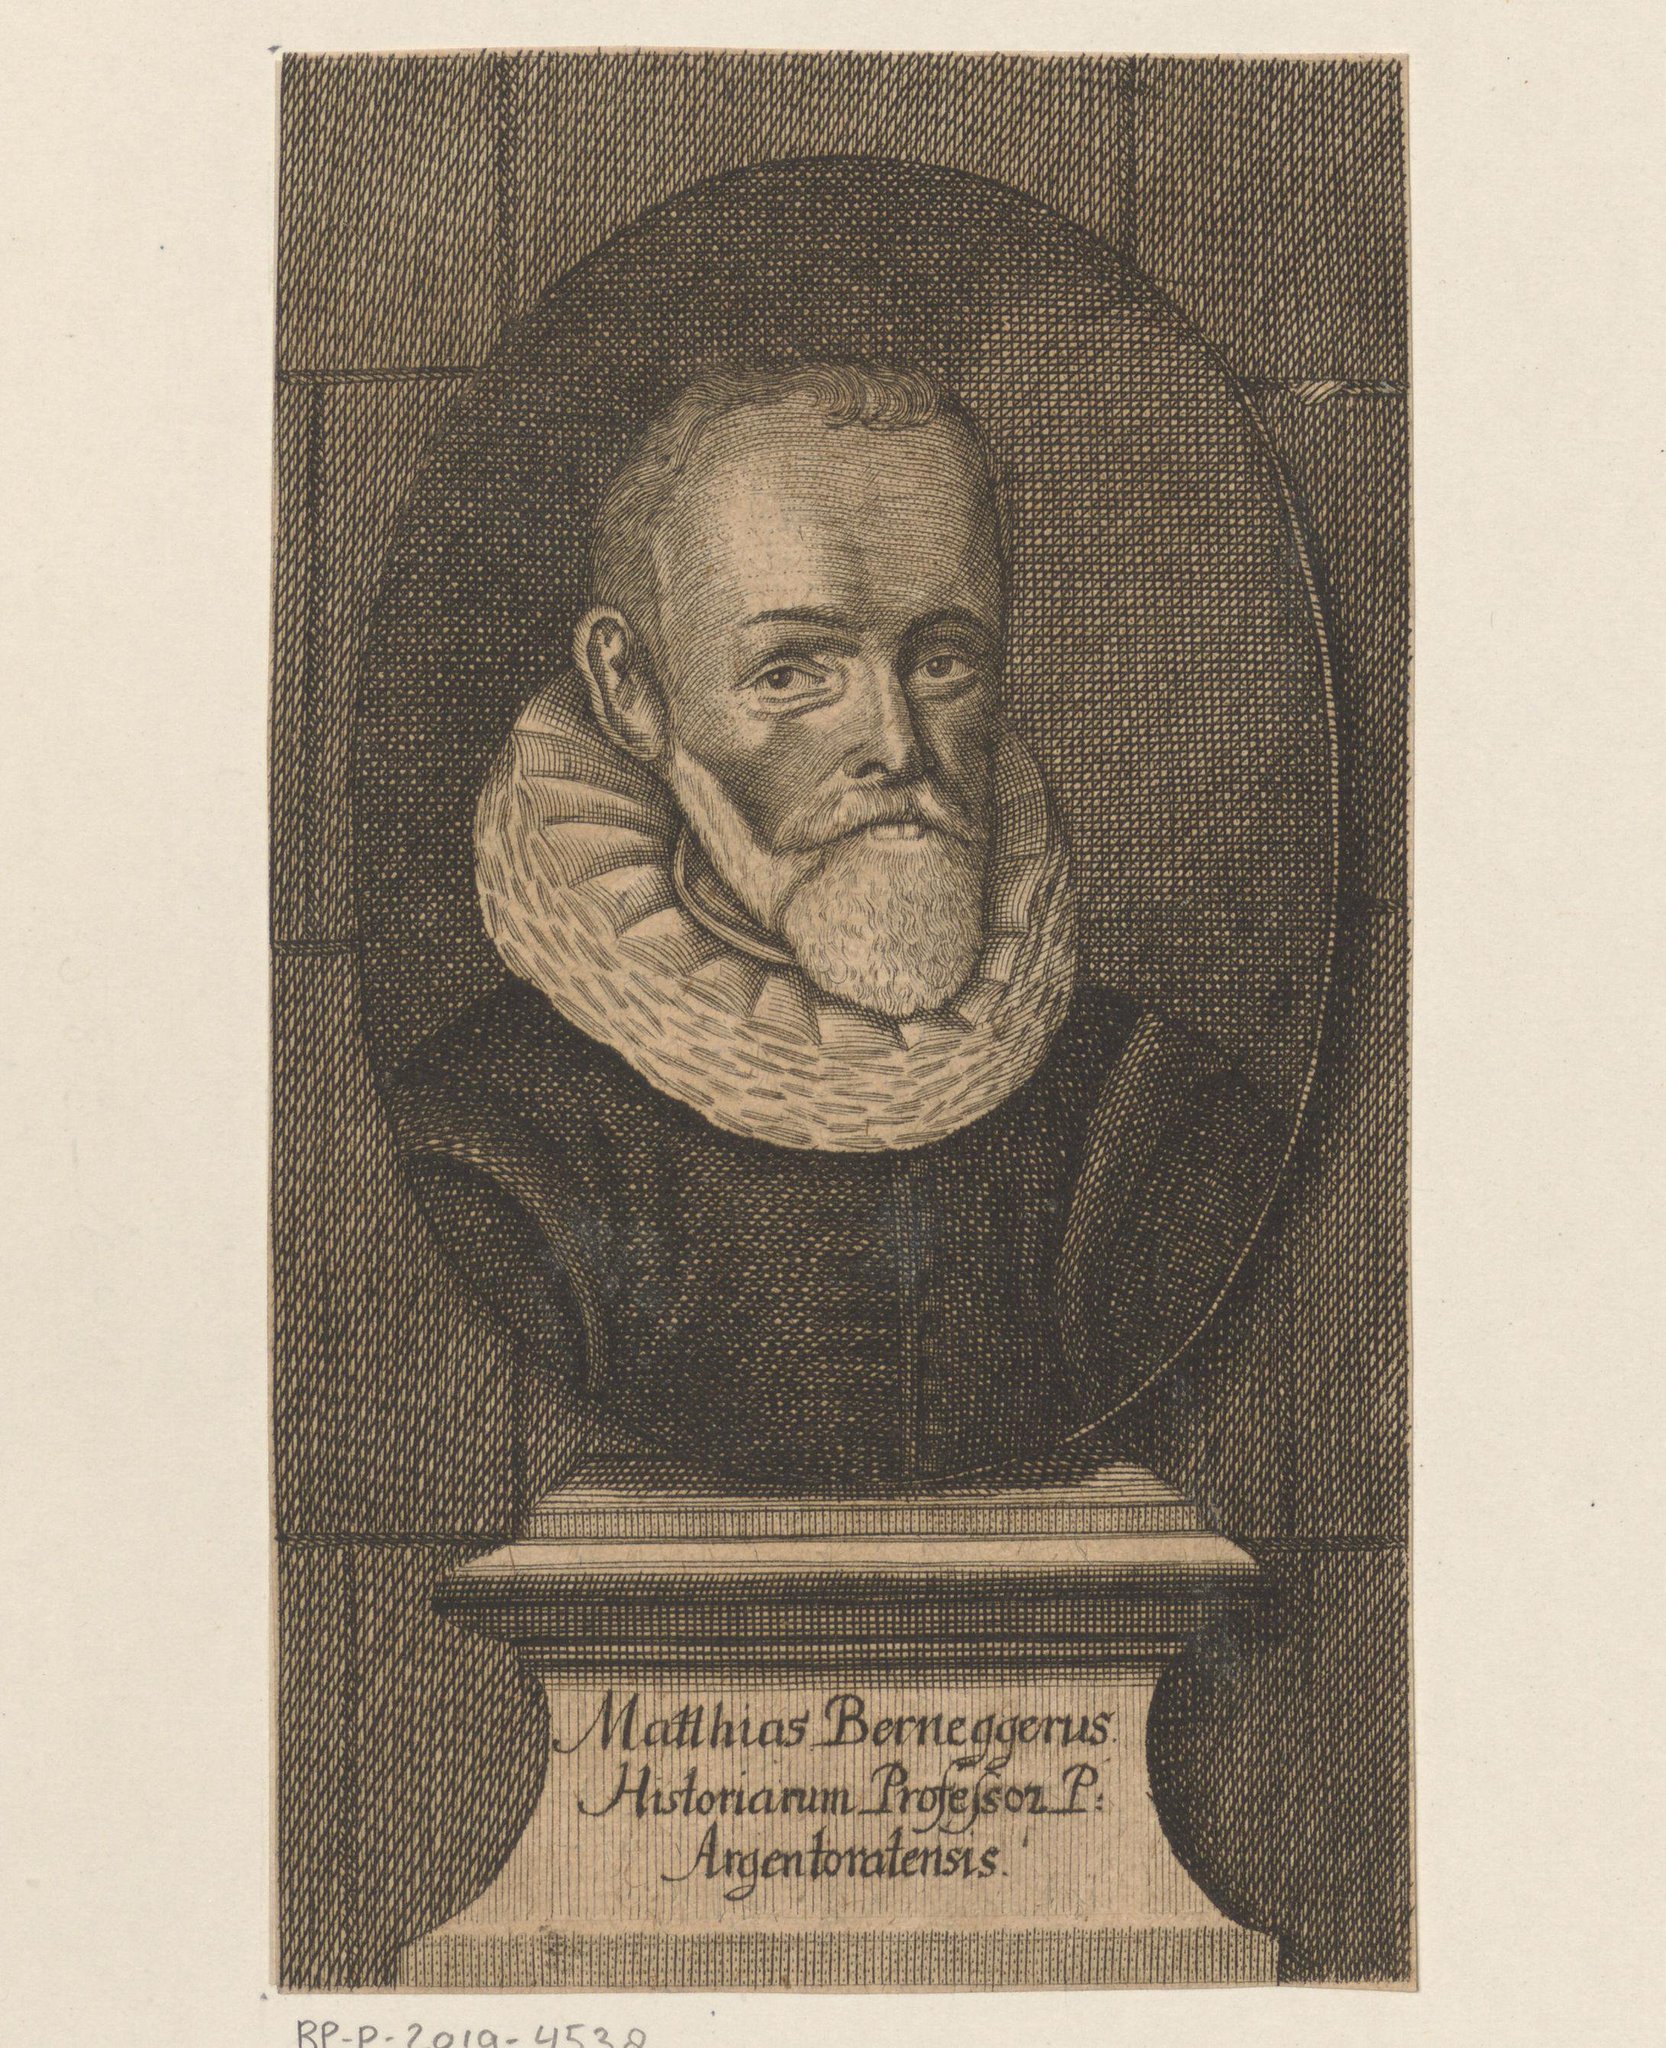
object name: print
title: Portret van Matthias Bernegger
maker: Anonymous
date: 1600-1649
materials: paper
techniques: engraving, etching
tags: matthias bernegger, historical persons